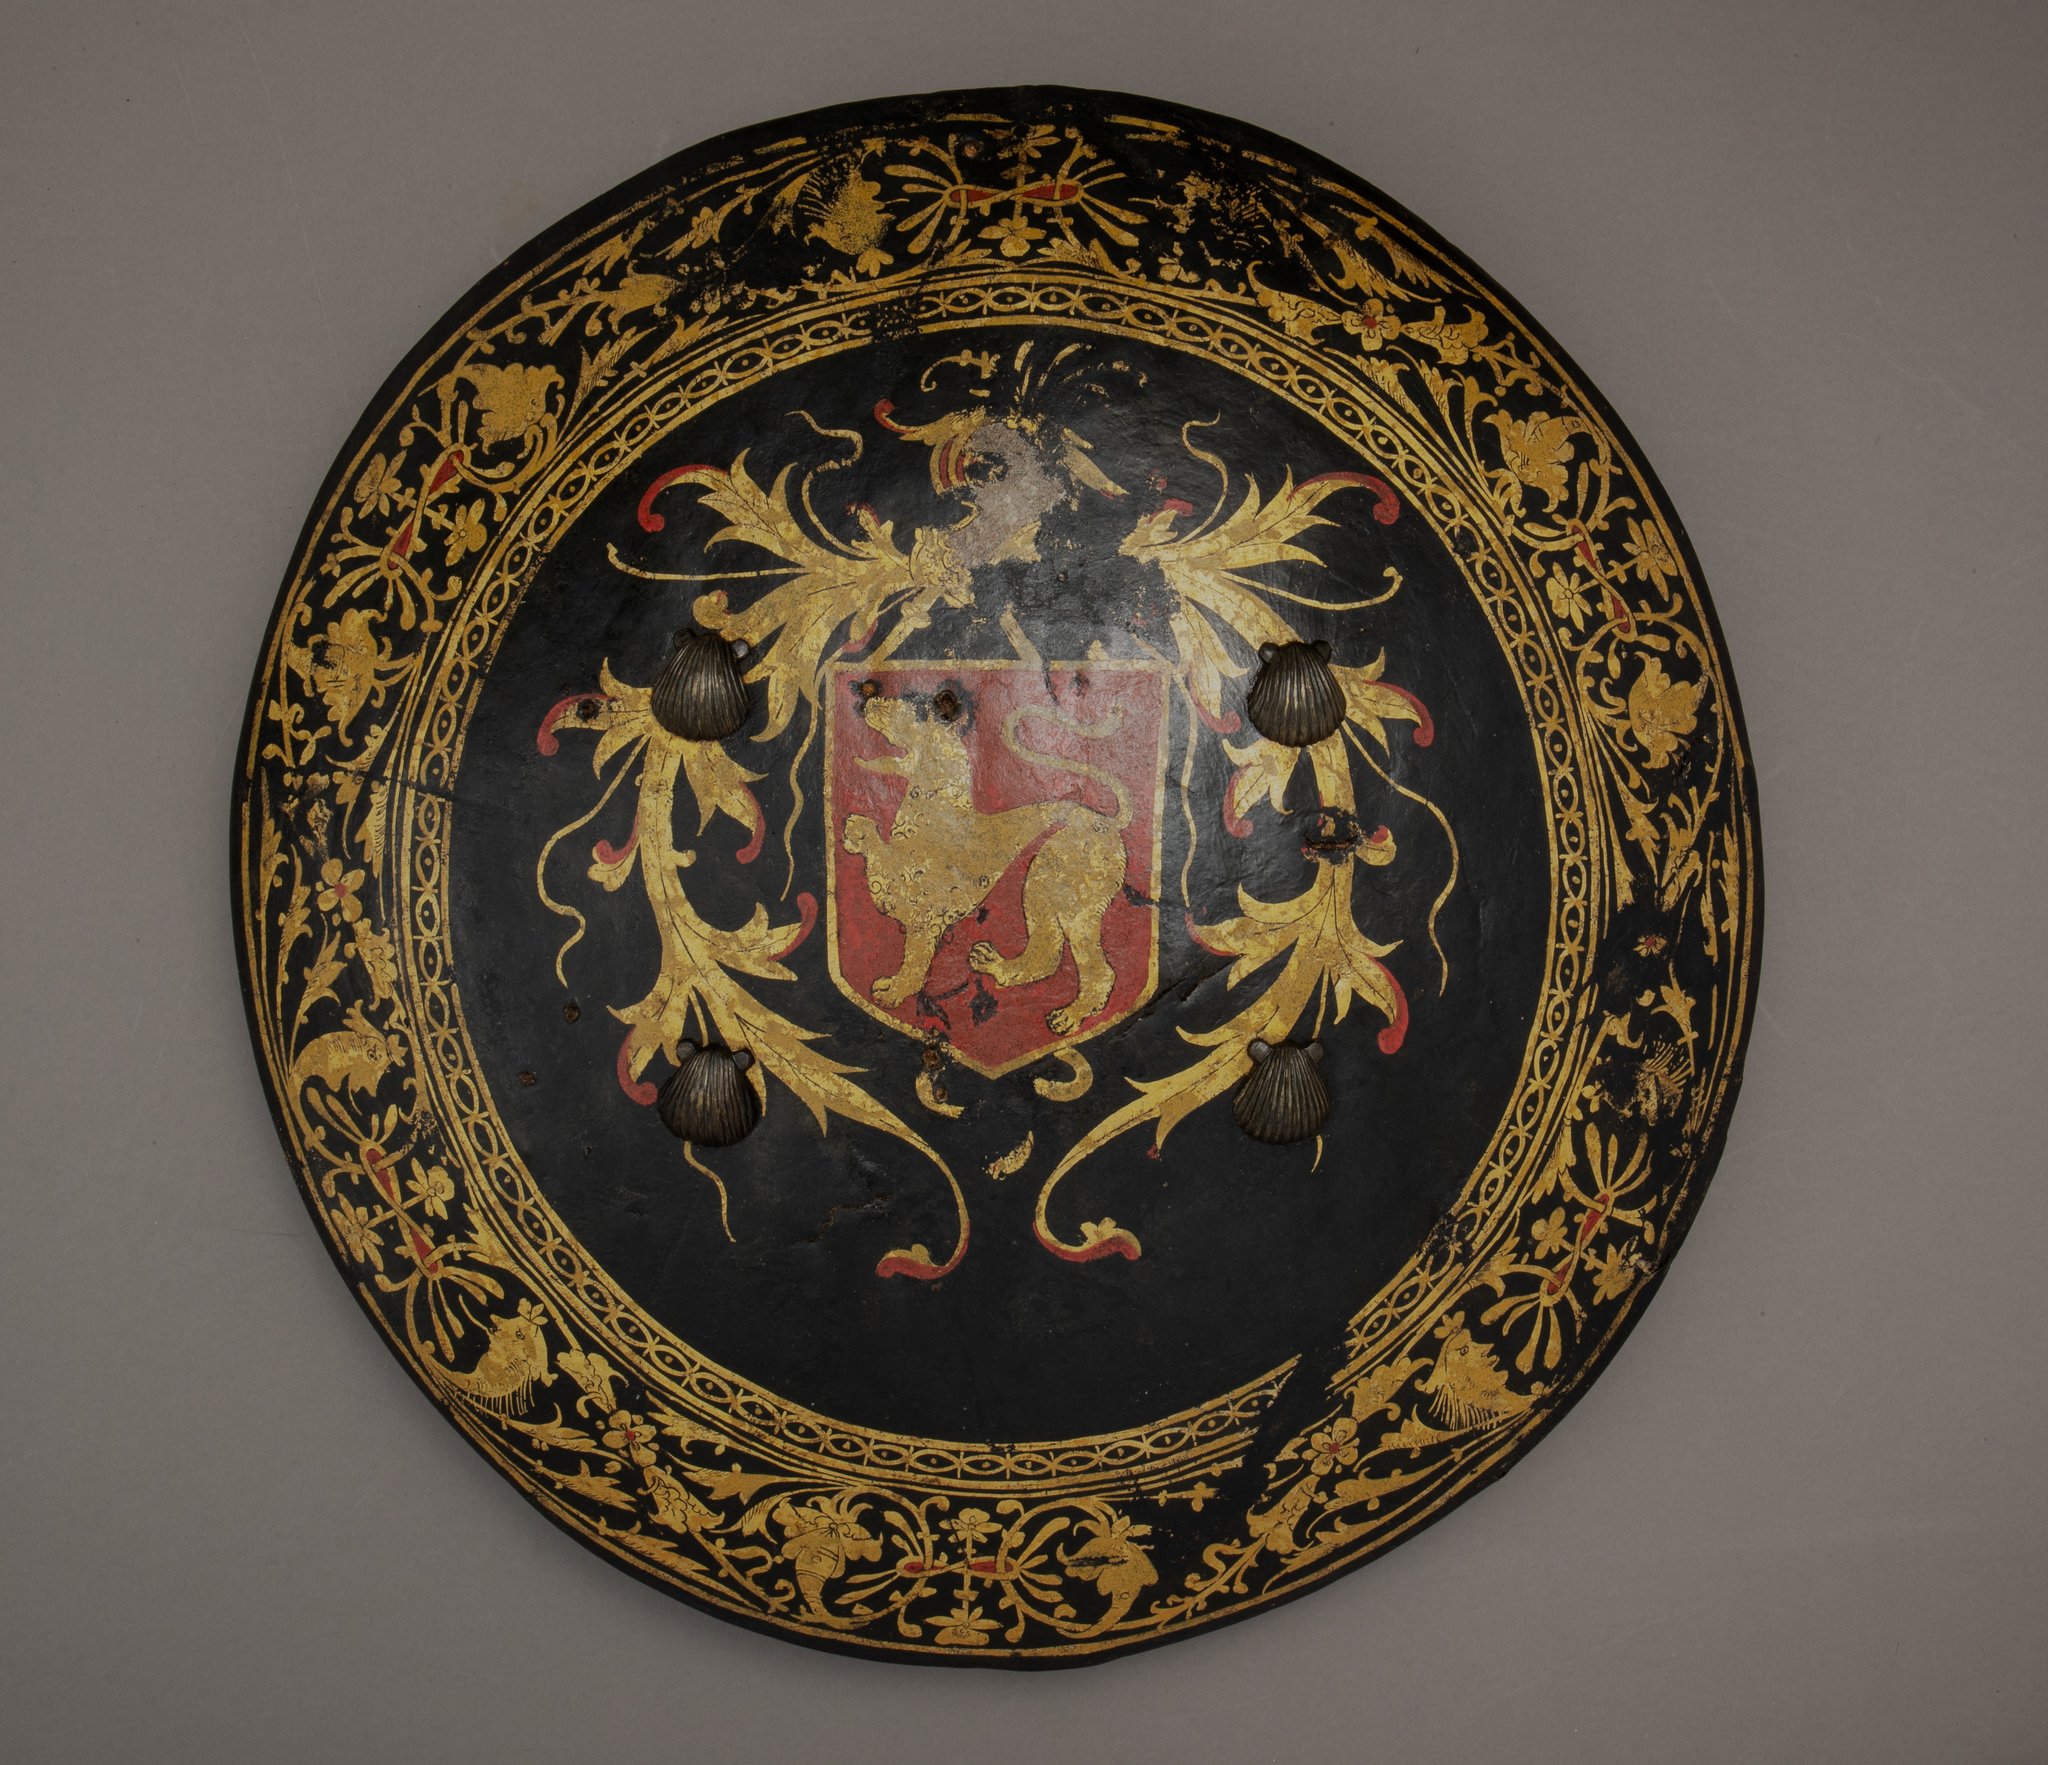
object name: shield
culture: indian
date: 1601-1650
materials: copper alloy, gesso, gold, iron, lacquer, leather, pigment, wood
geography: southeast asia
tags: coat of arms